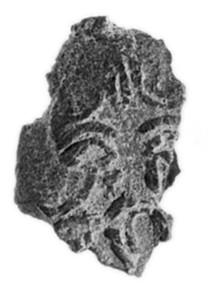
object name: sealing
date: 1981-1640 BCE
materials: mud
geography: egypt